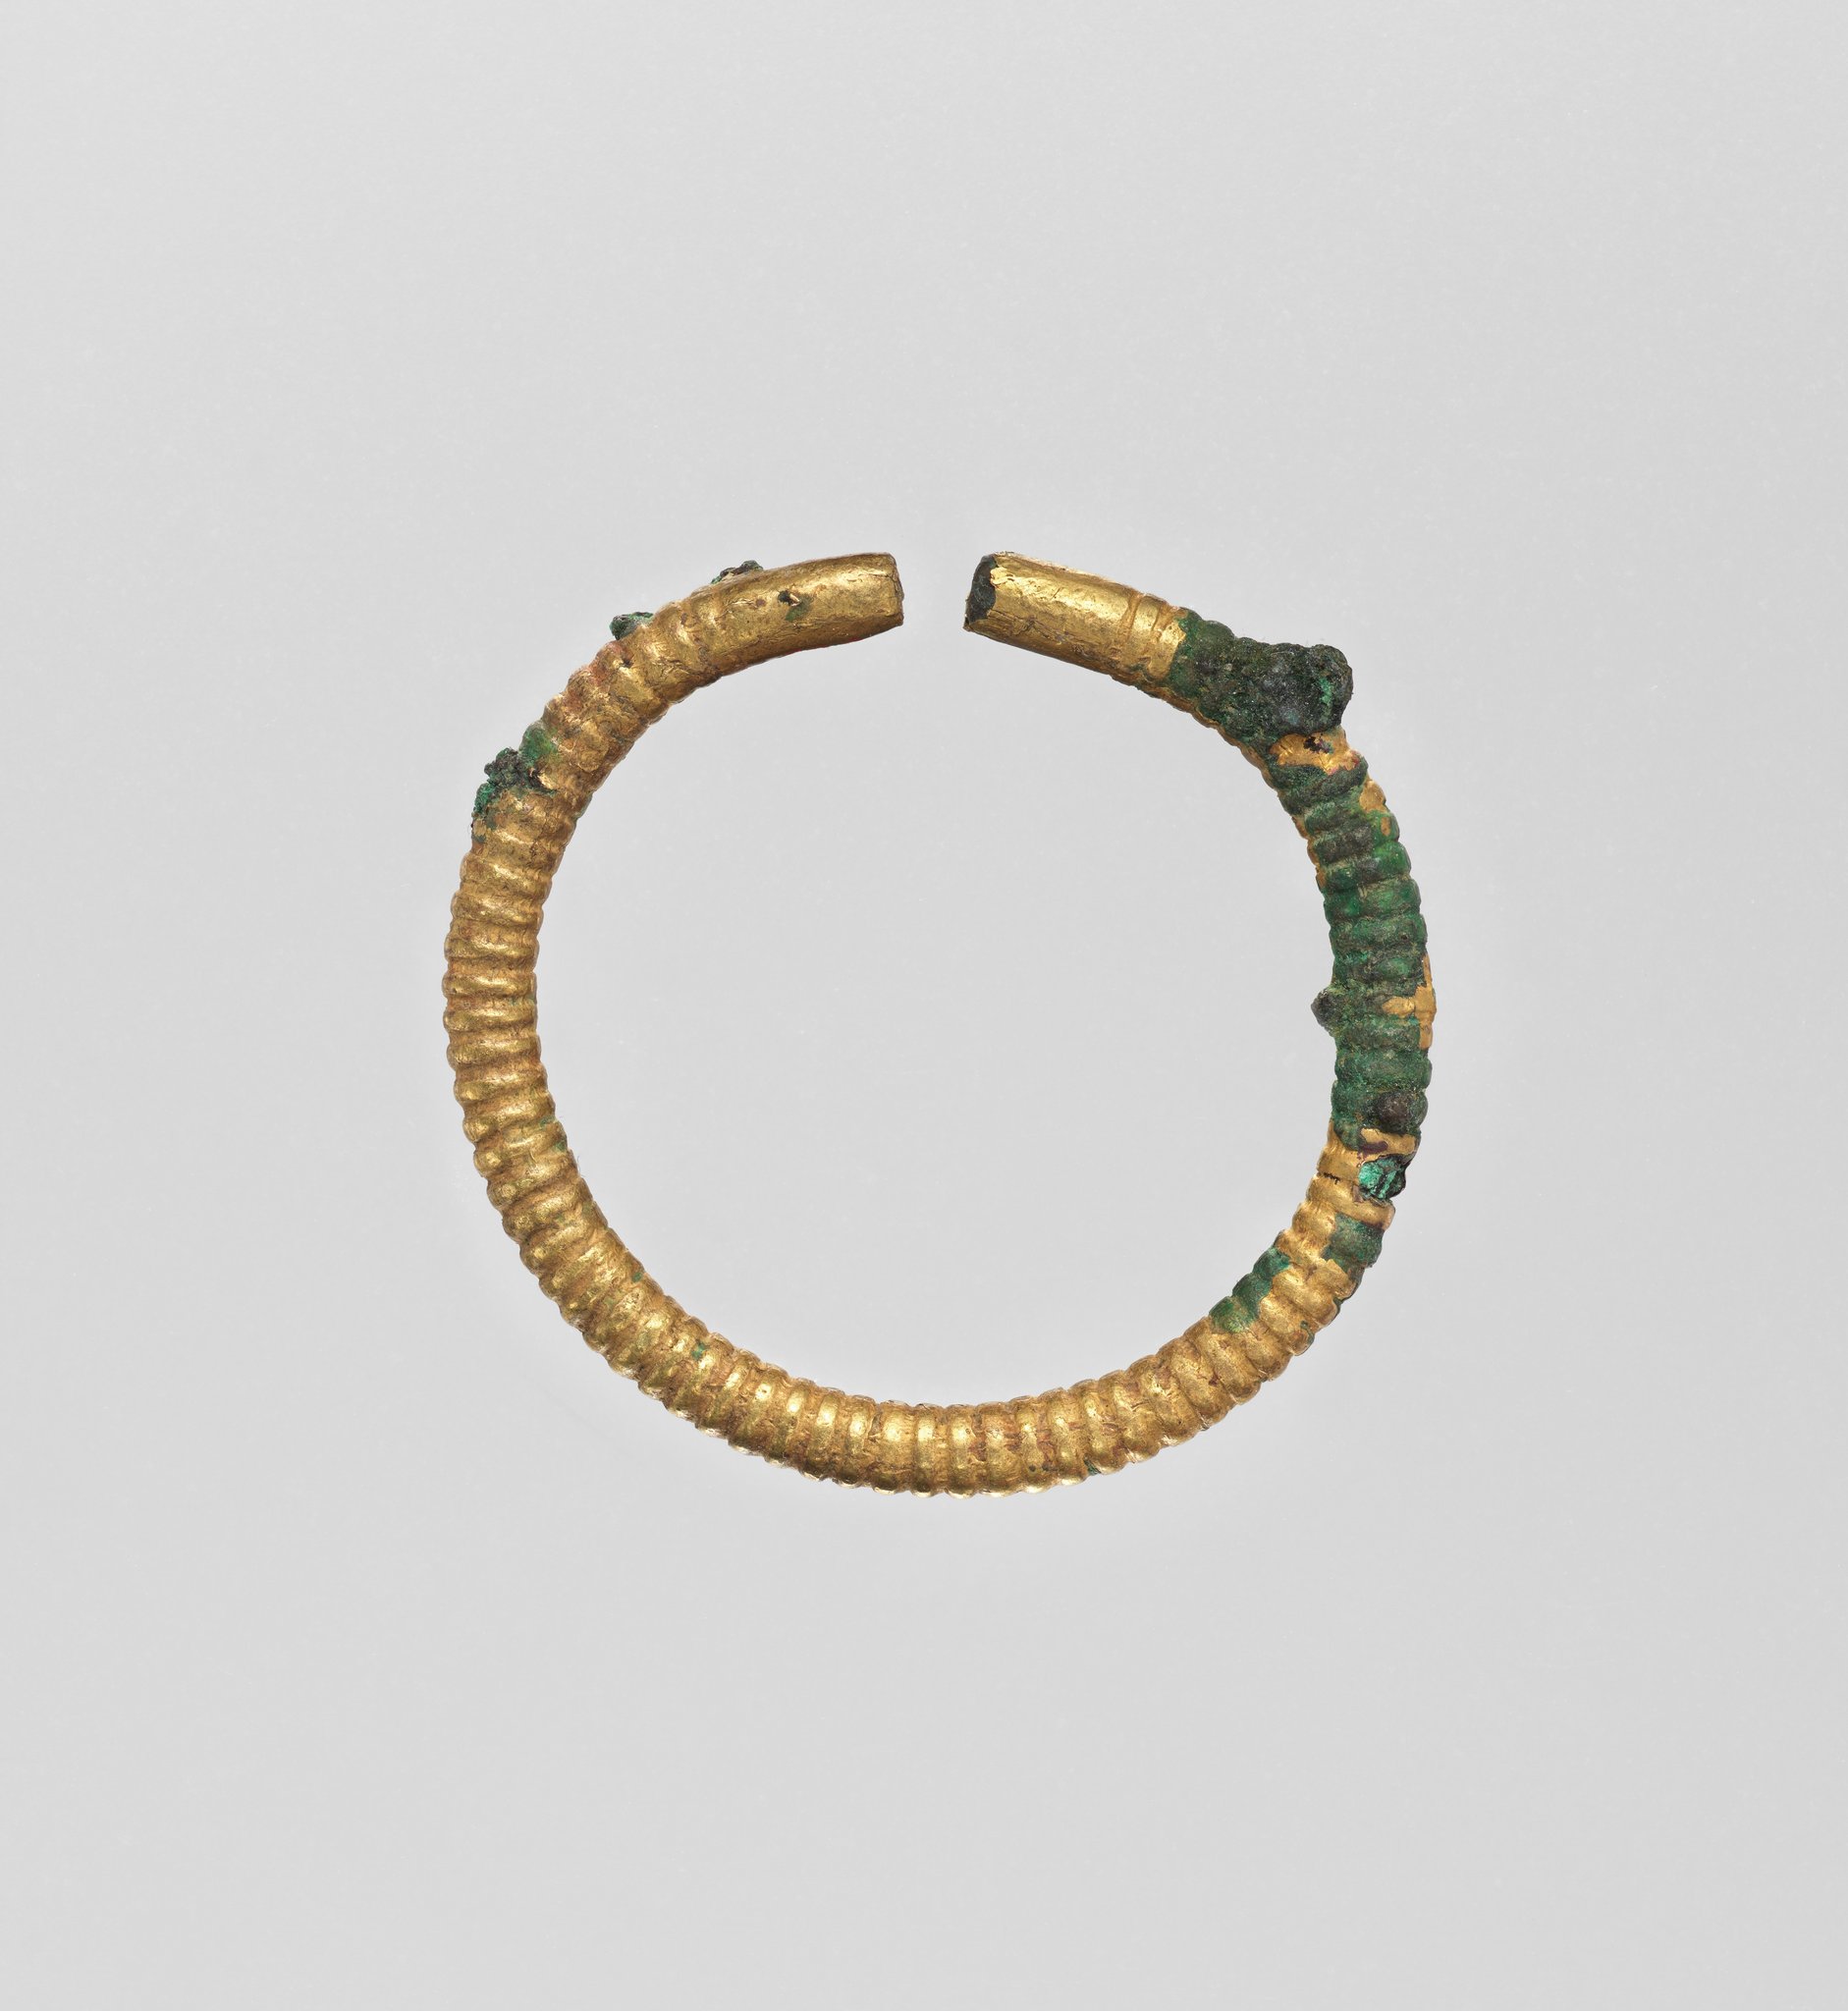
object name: bracelet bangle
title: Bracelet (bangle)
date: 332-330 BCE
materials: gold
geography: egypt